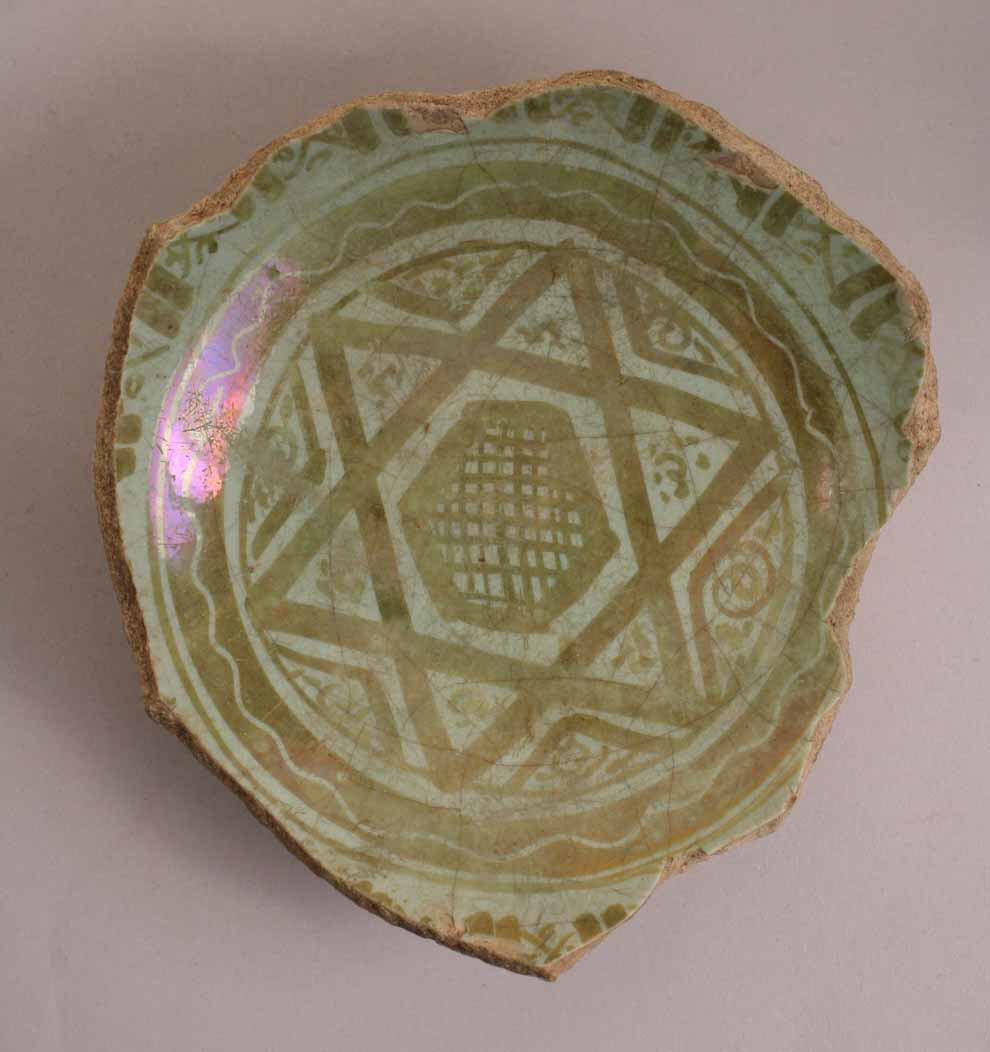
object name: ceramic fragment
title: Fragment of a Bowl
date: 901-1200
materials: earthenware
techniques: glazing, painting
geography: egypt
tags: stars